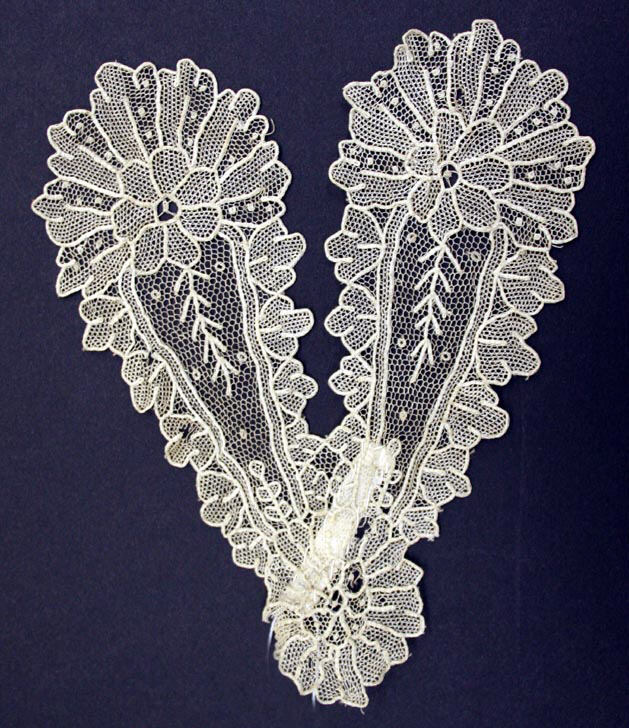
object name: jabot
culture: american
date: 1860-1869